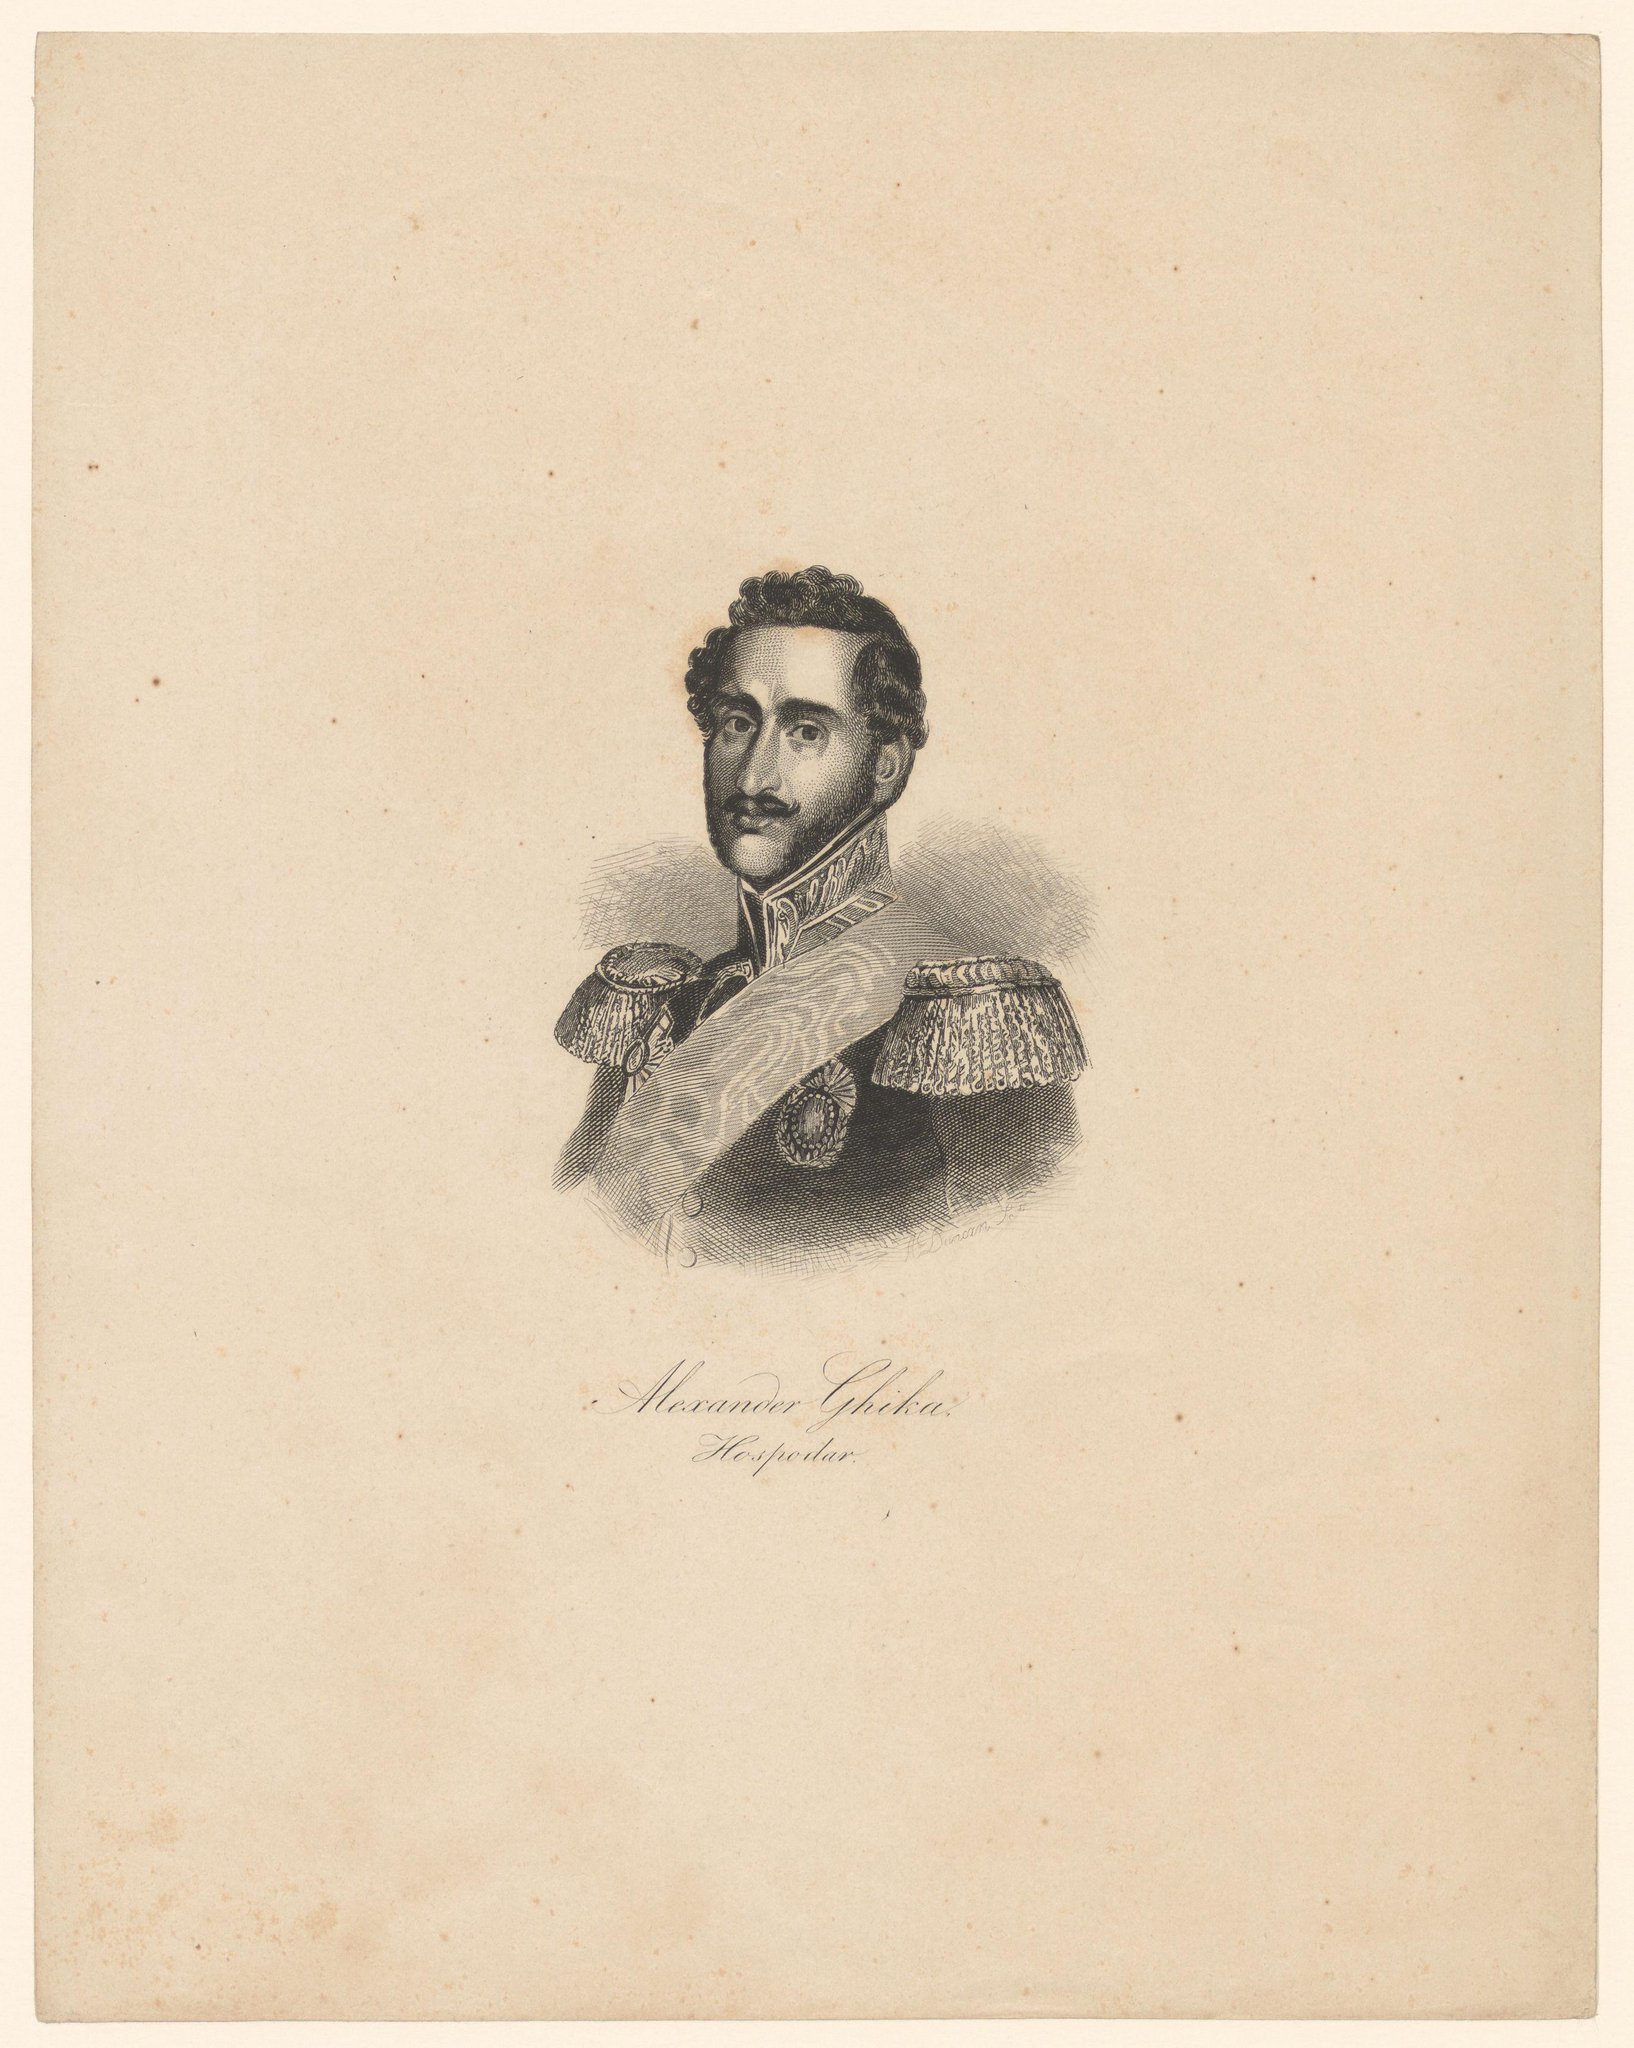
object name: print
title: Portret van Alexandru Ghica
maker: andrew duncan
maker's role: print maker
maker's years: 1795-1855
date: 1834-1895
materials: paper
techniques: engraving, etching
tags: italy, historical persons, officer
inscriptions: collector's mark: Lugt 2228